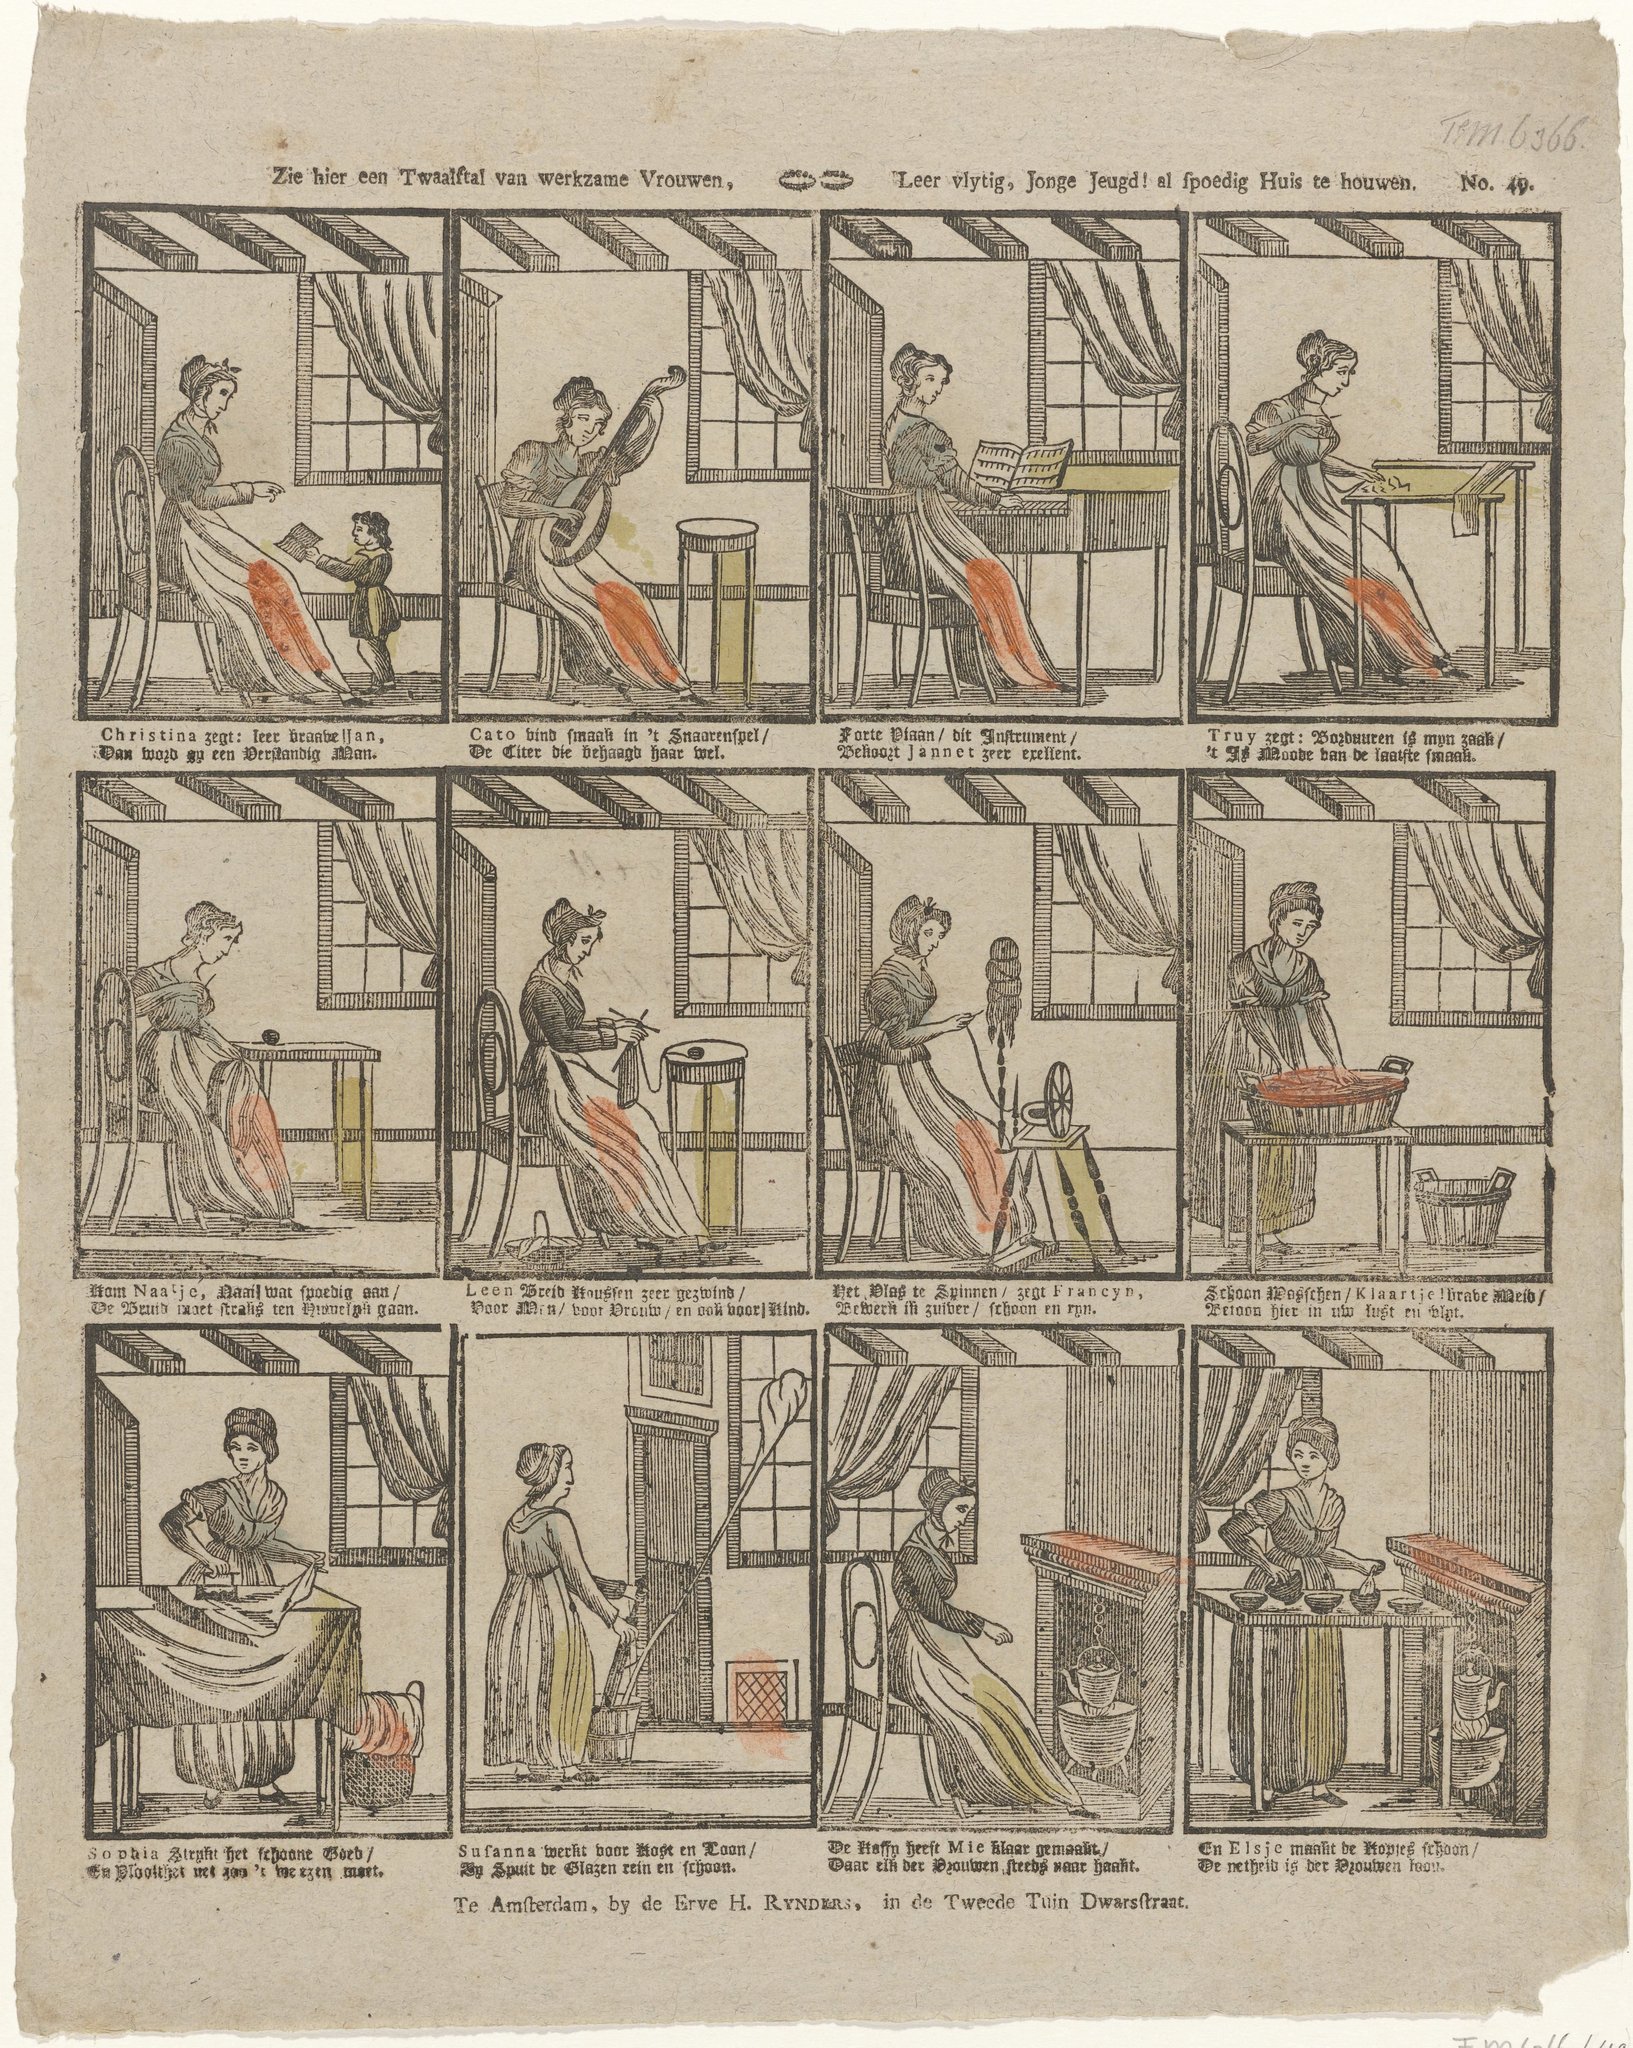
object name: print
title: Zie hier een Twaalftal van werkzame Vrouwen, Leer vlytig, Jonge Jeigd! al spoedig Huis te houwen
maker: Anonymous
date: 1830-1855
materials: paper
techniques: colour, letterpress printing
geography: netherlands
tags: household chores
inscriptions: collector's mark: Lugt 2228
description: Blad met twaalf voorstellingen van huishoudelijke taken en bezigheden voor de vrouw. Onder elk plaatje een tweeregelig versje. Genummerd rechtsboven: No. 49. Ca. 1830-1855.